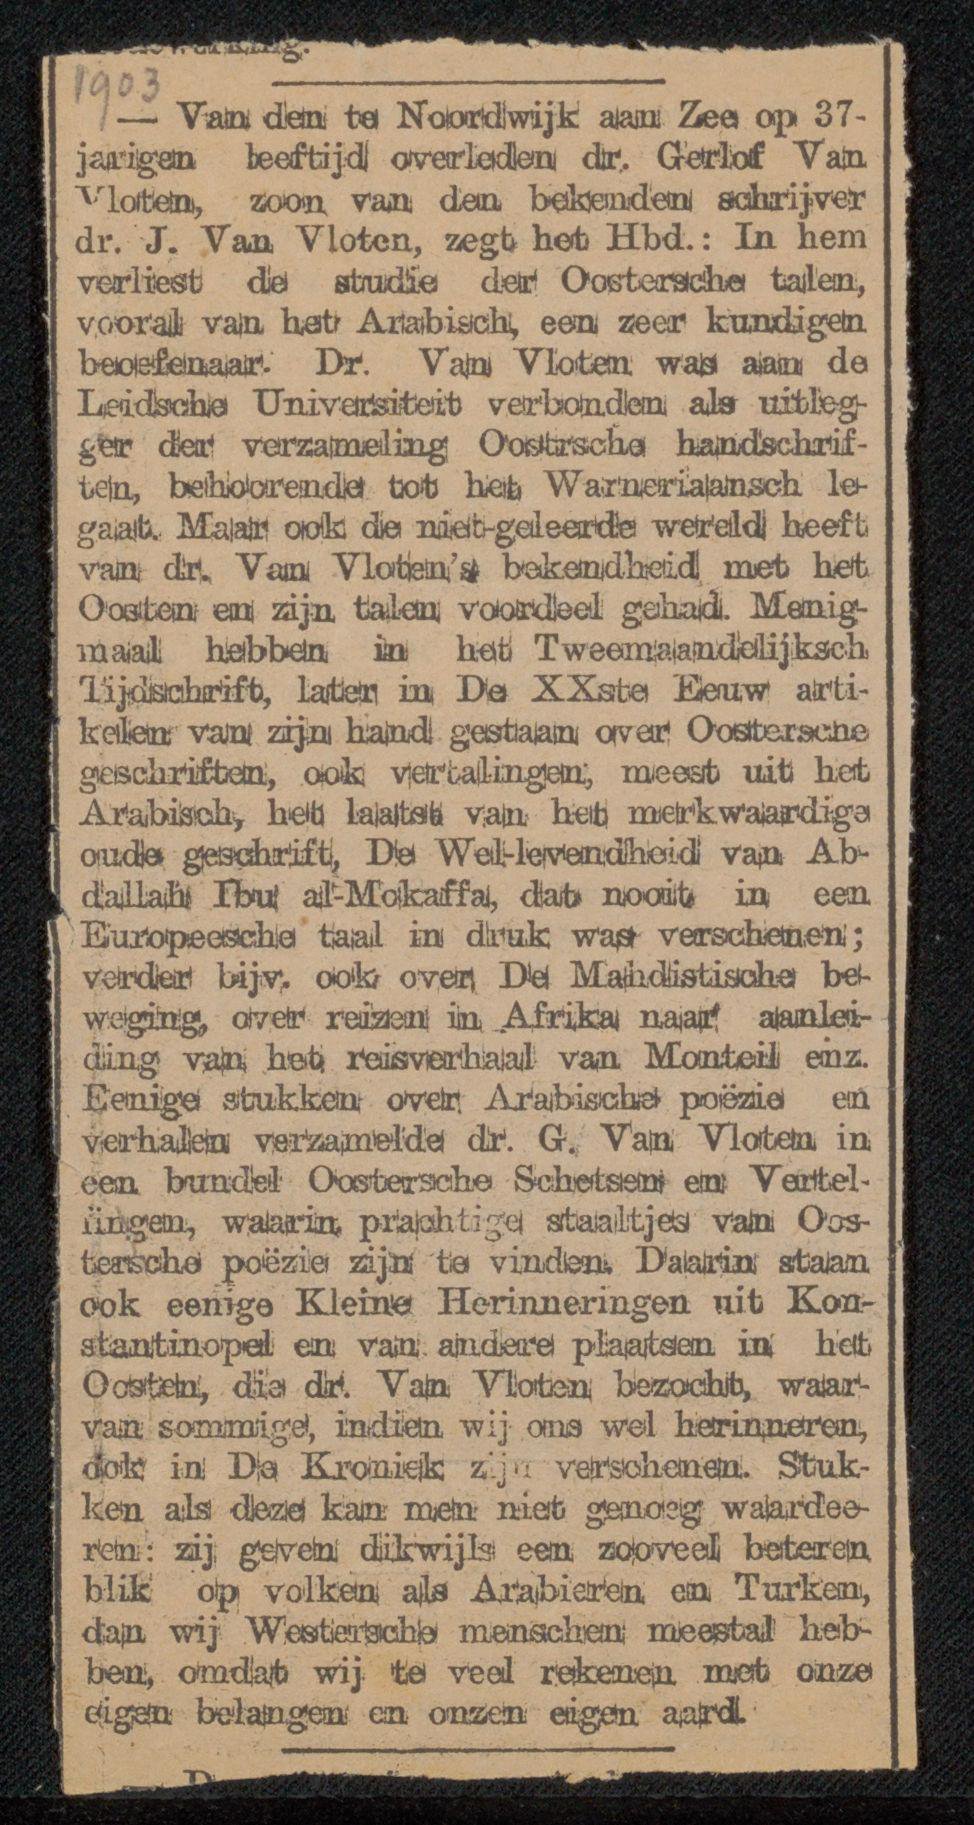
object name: newspaper clipping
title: Krantenknipsel uit archief Philip Zilcken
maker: Anonymous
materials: paper, ink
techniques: printing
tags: gerlof van vloten, painter, philip zilcken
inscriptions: collector's mark: ‘RPK’